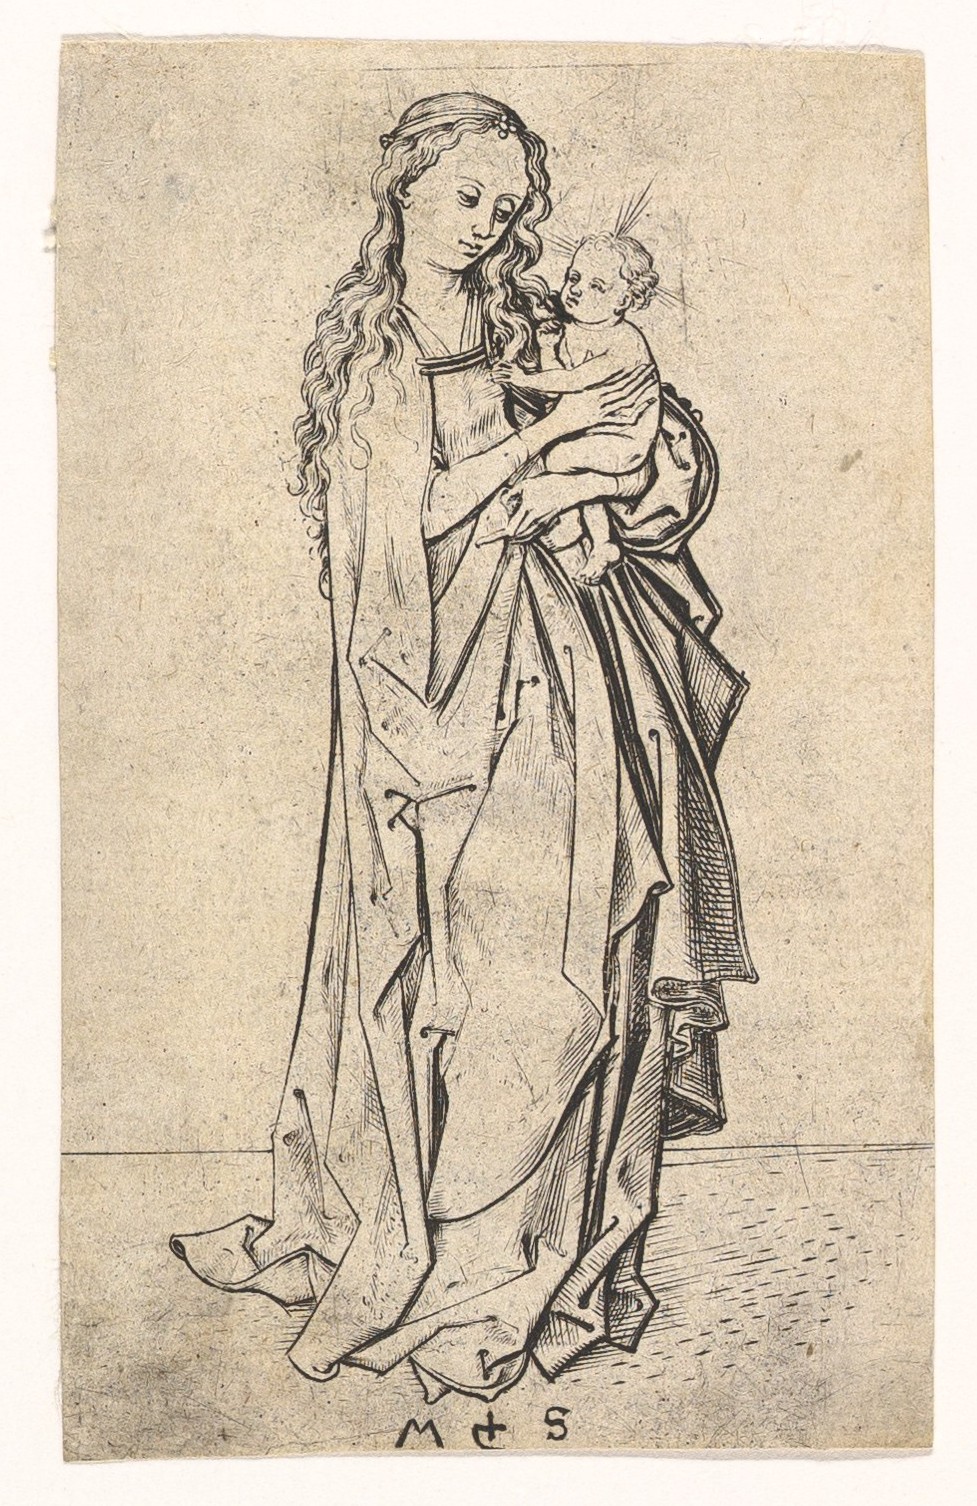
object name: print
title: The Small Madonna and Child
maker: martin schongauer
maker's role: artist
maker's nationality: german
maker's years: 1430-1491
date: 1470-1491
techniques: engraving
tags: madonna and child